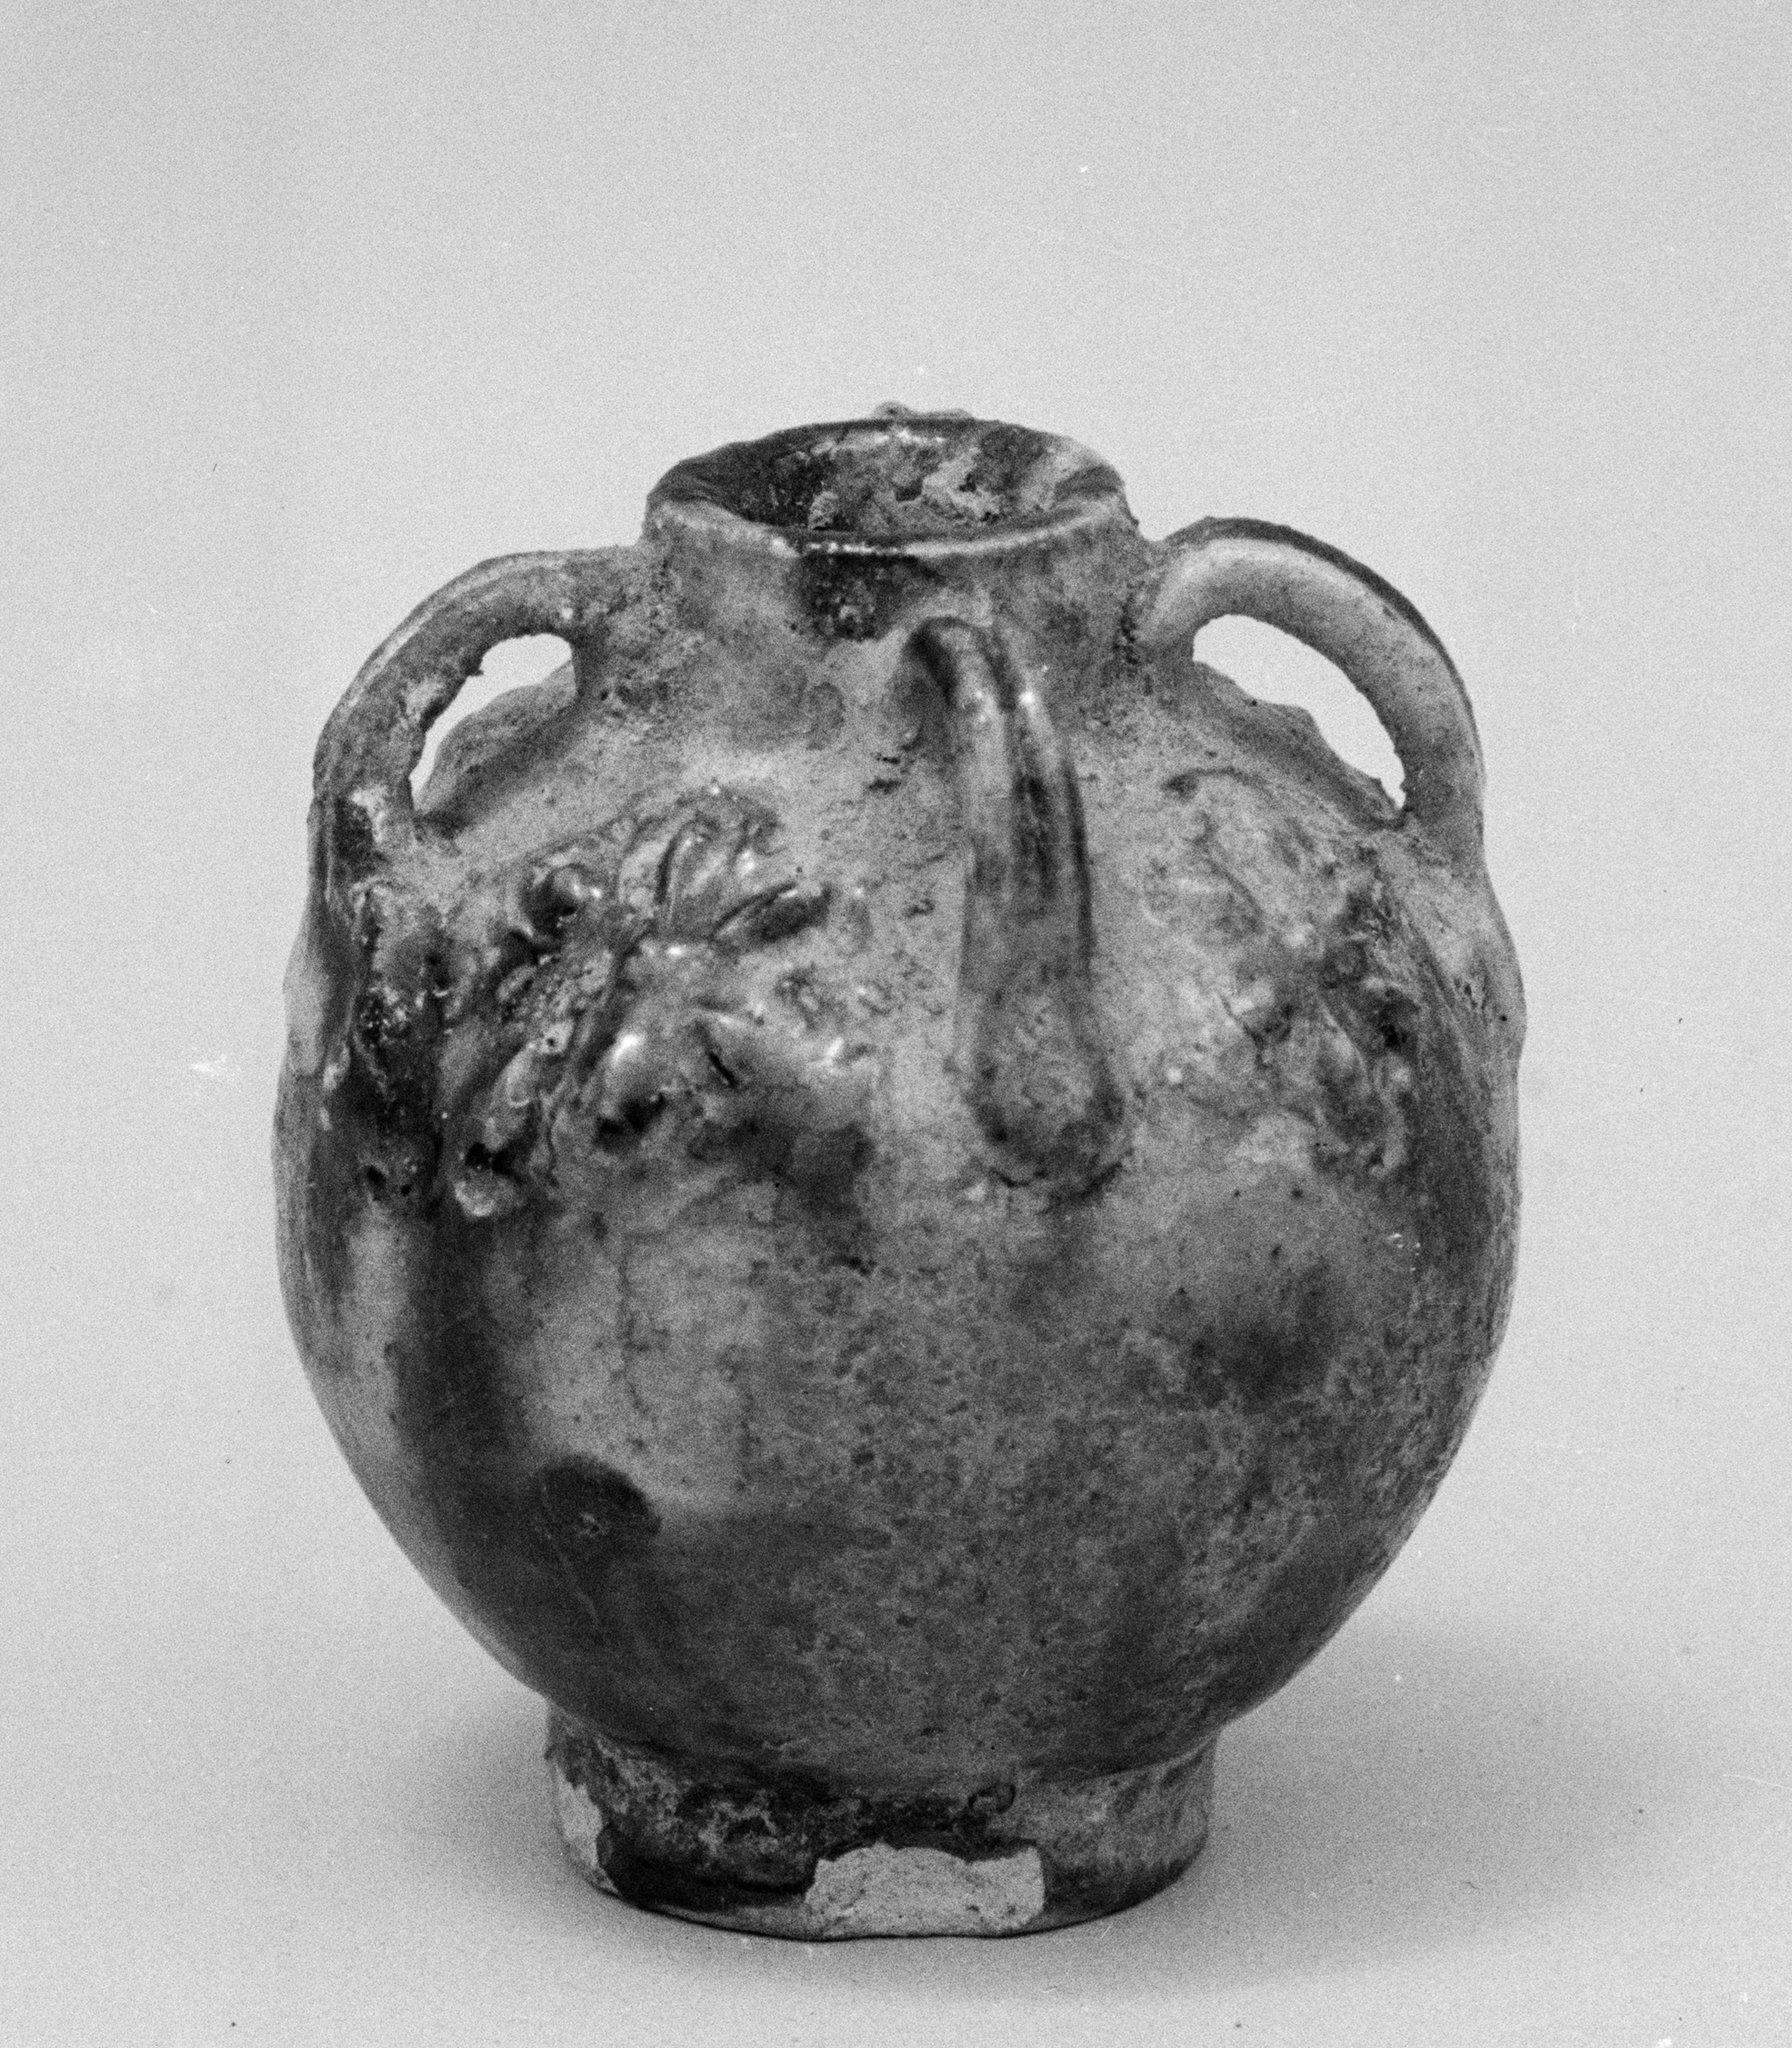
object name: jar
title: Jar with loop handles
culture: chinese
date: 618-907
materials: earthenware, glaze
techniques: molding